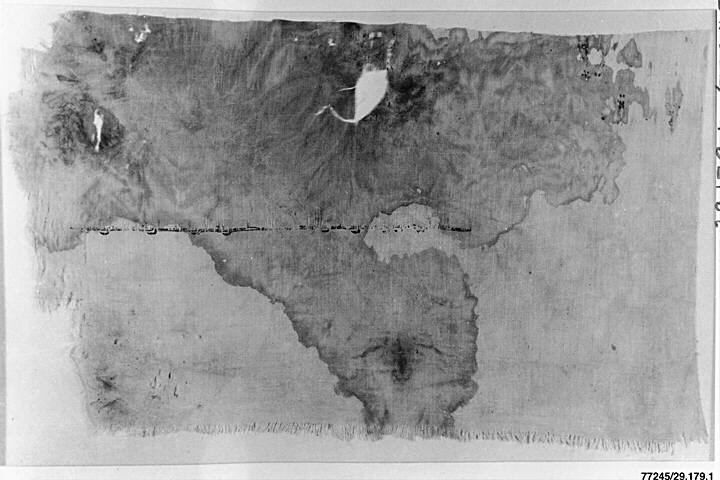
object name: textile fragment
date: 908-932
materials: linen, silk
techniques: tapestry, weave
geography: egypt